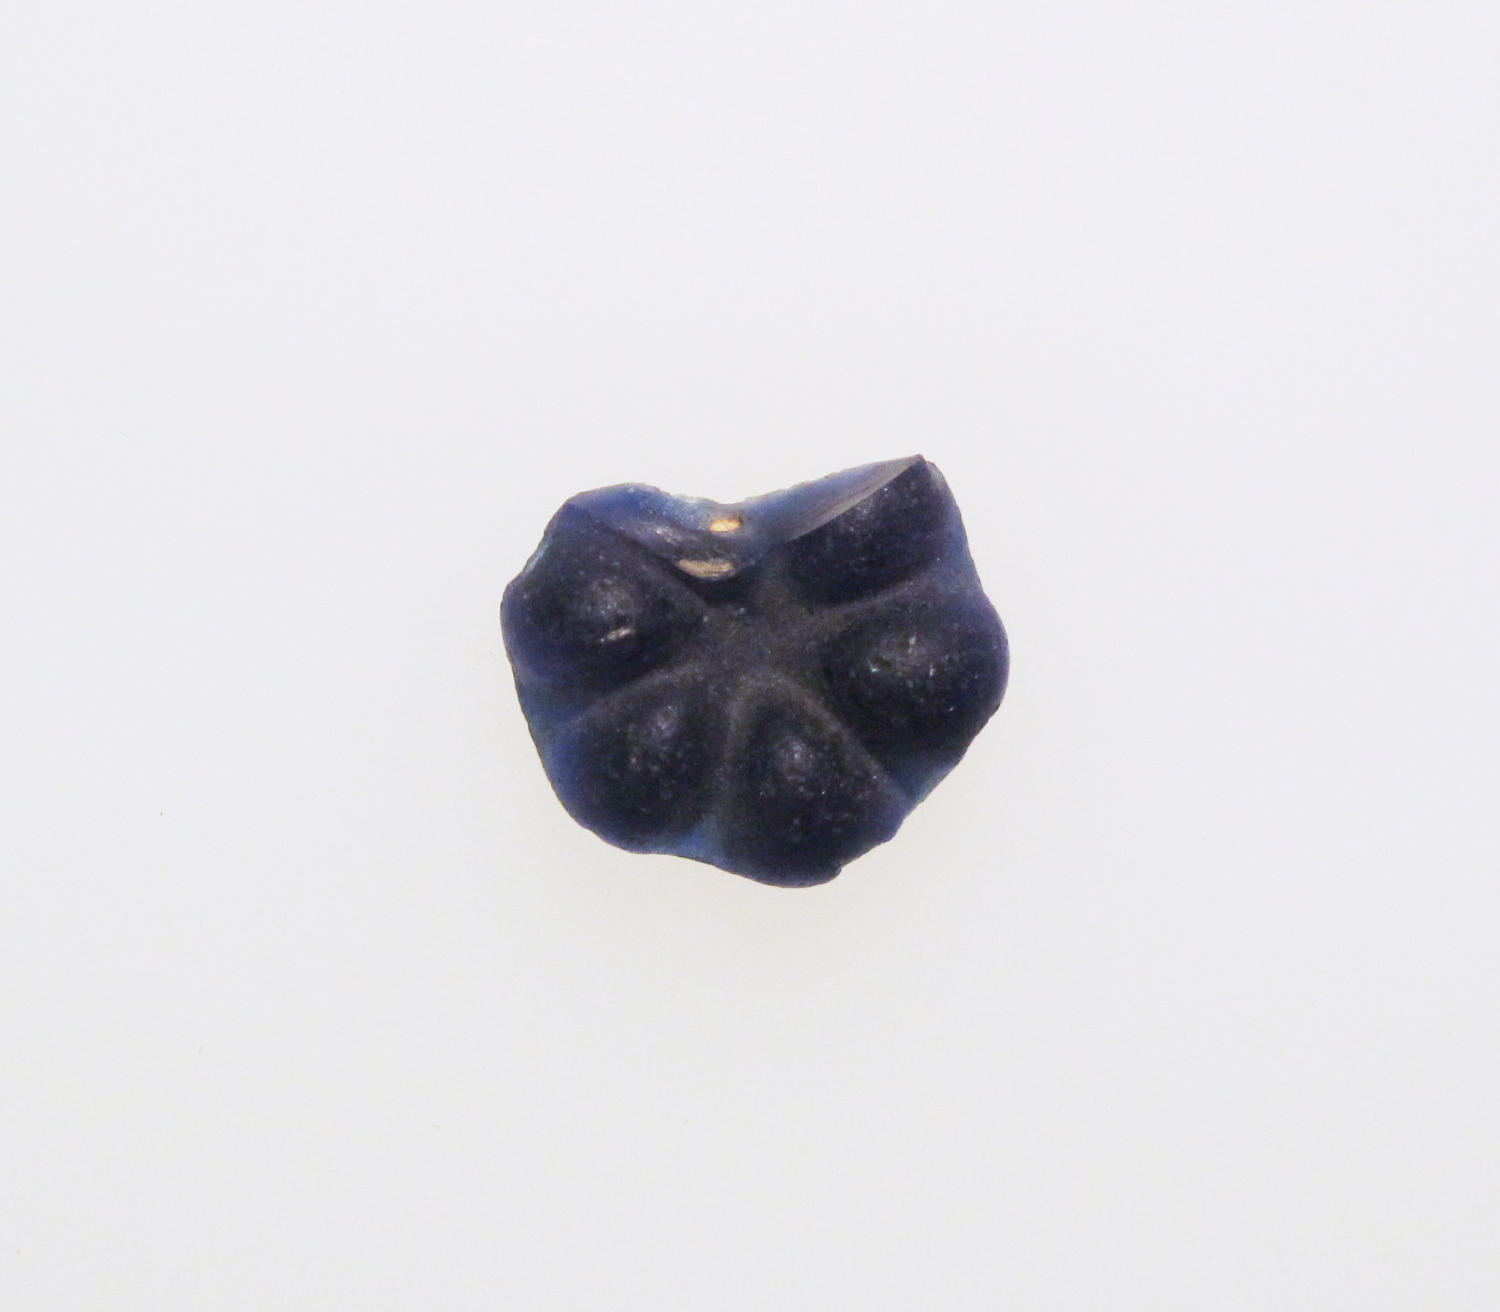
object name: bead in the form of a rosette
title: Glass bead in the form of a rosette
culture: roman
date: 1-33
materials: glass